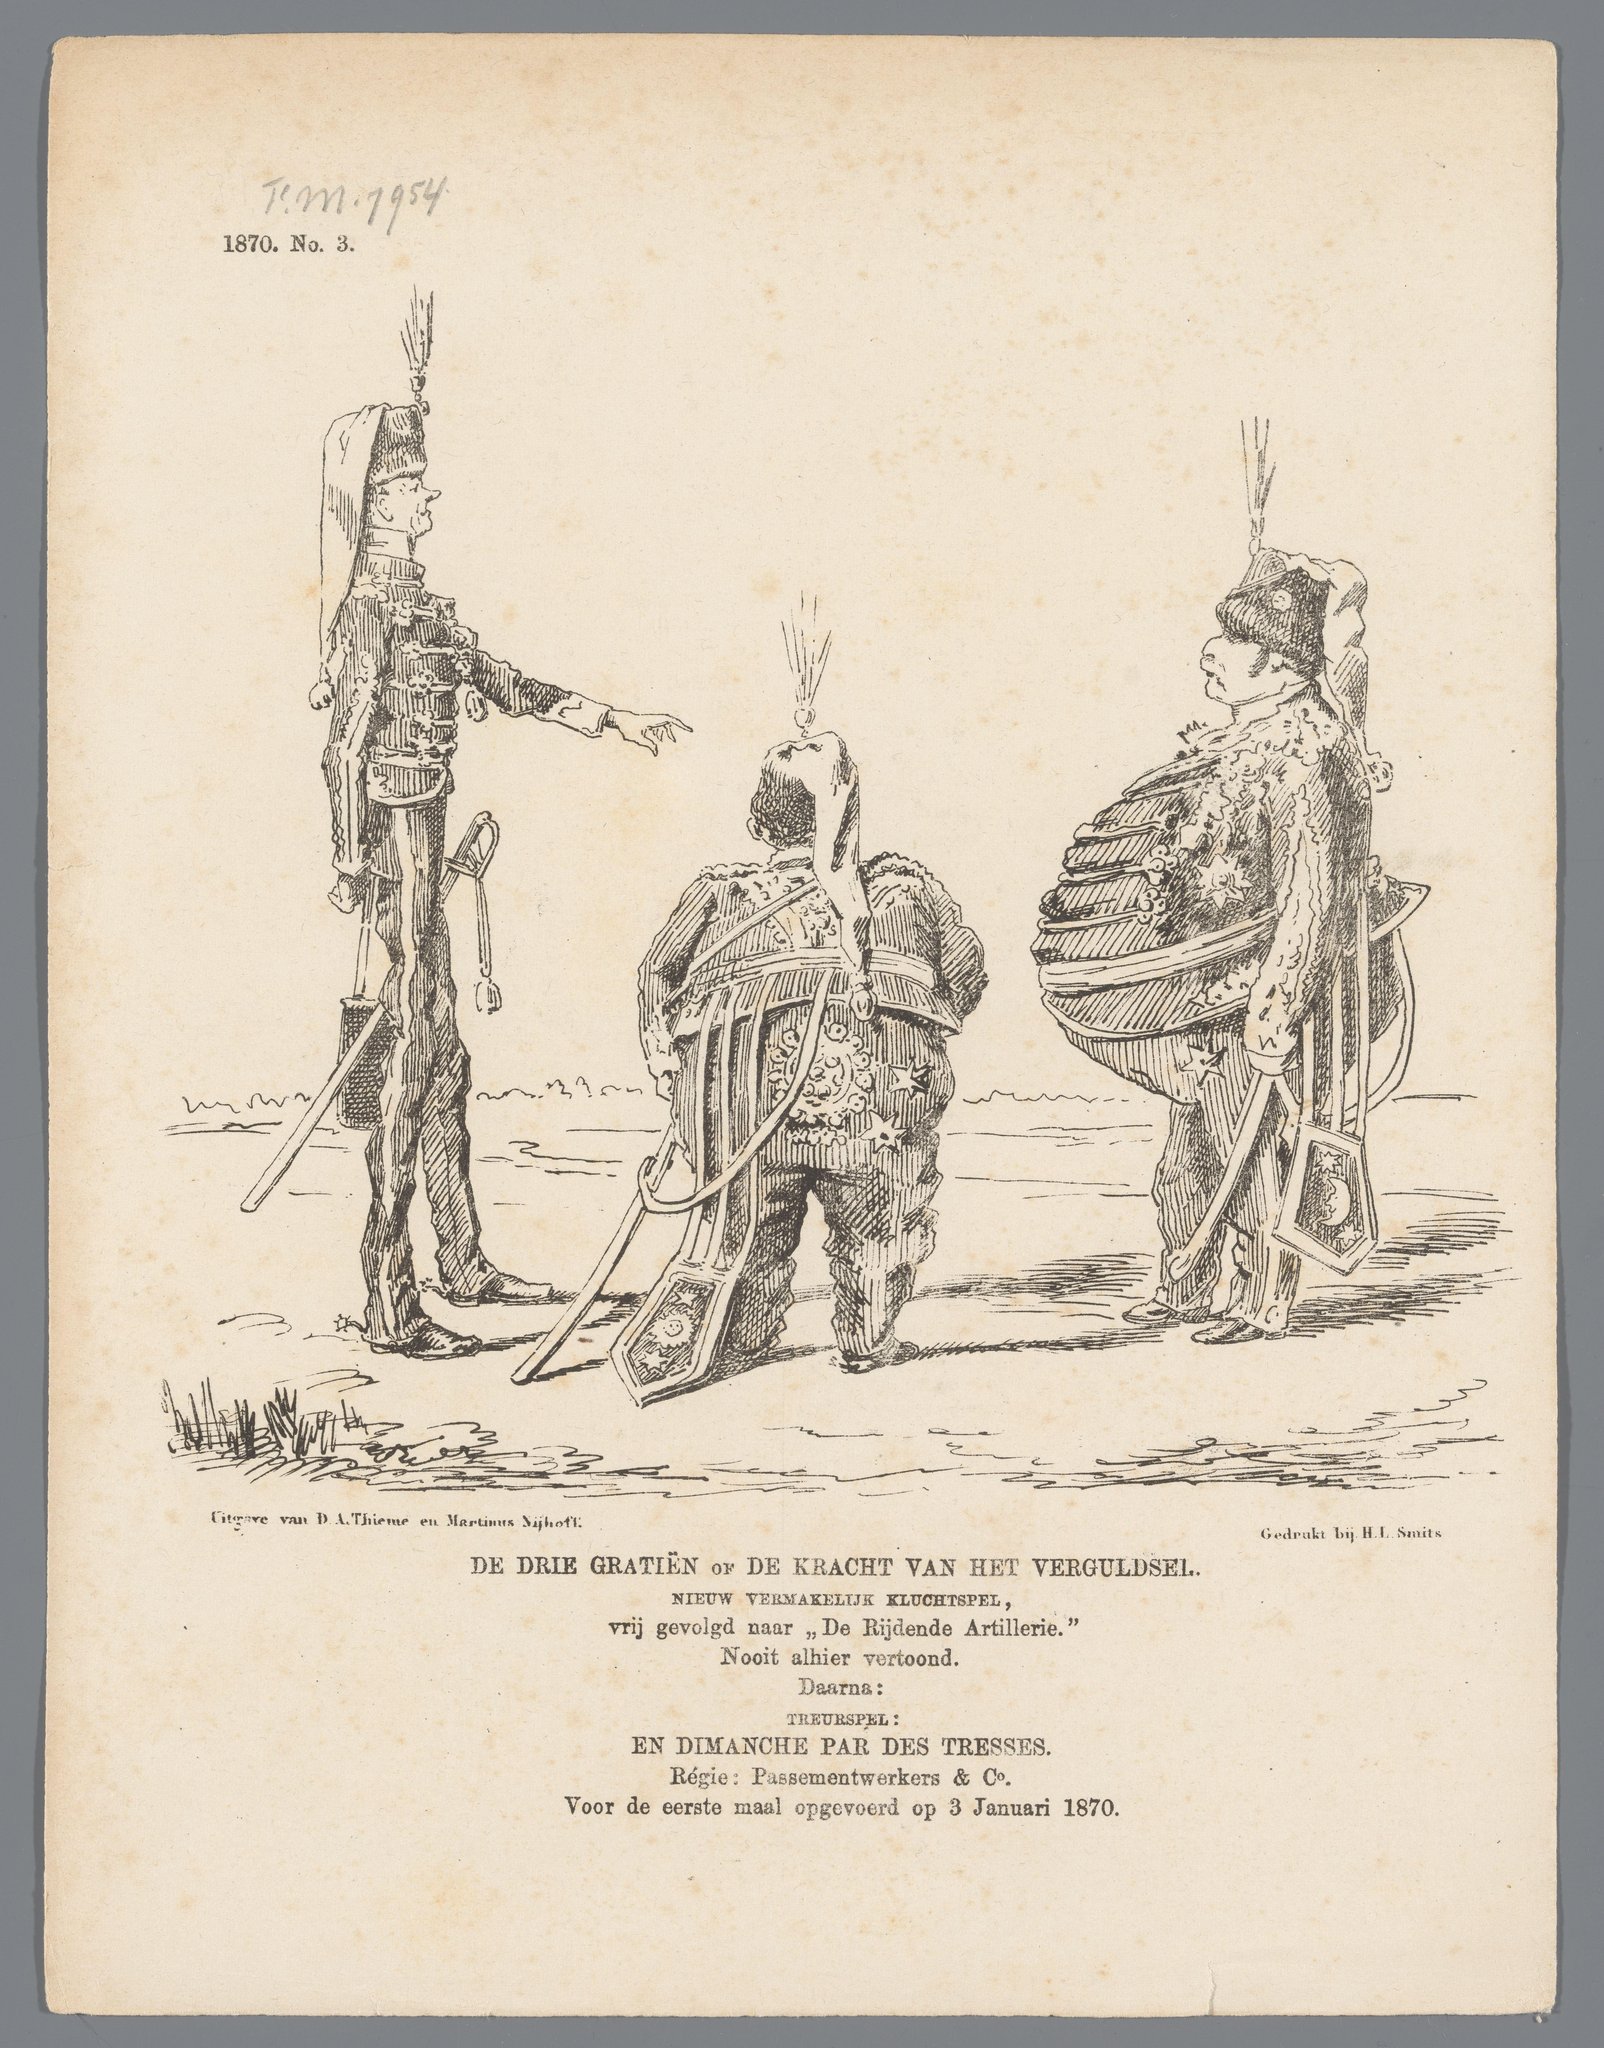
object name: print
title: De Drie Gratiën of De Kracht van het Verguldsel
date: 1870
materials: paper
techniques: lithograph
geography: arnhem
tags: (military) uniforms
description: Spotprent op de overladen uniformen van de generaals. Drie generaals in uniformen zwaar beladen met verguldsel en andere versieringen. Plaat verschenen bij het weekblad De Nederlandsche Spectator, nr. 3, 1870.